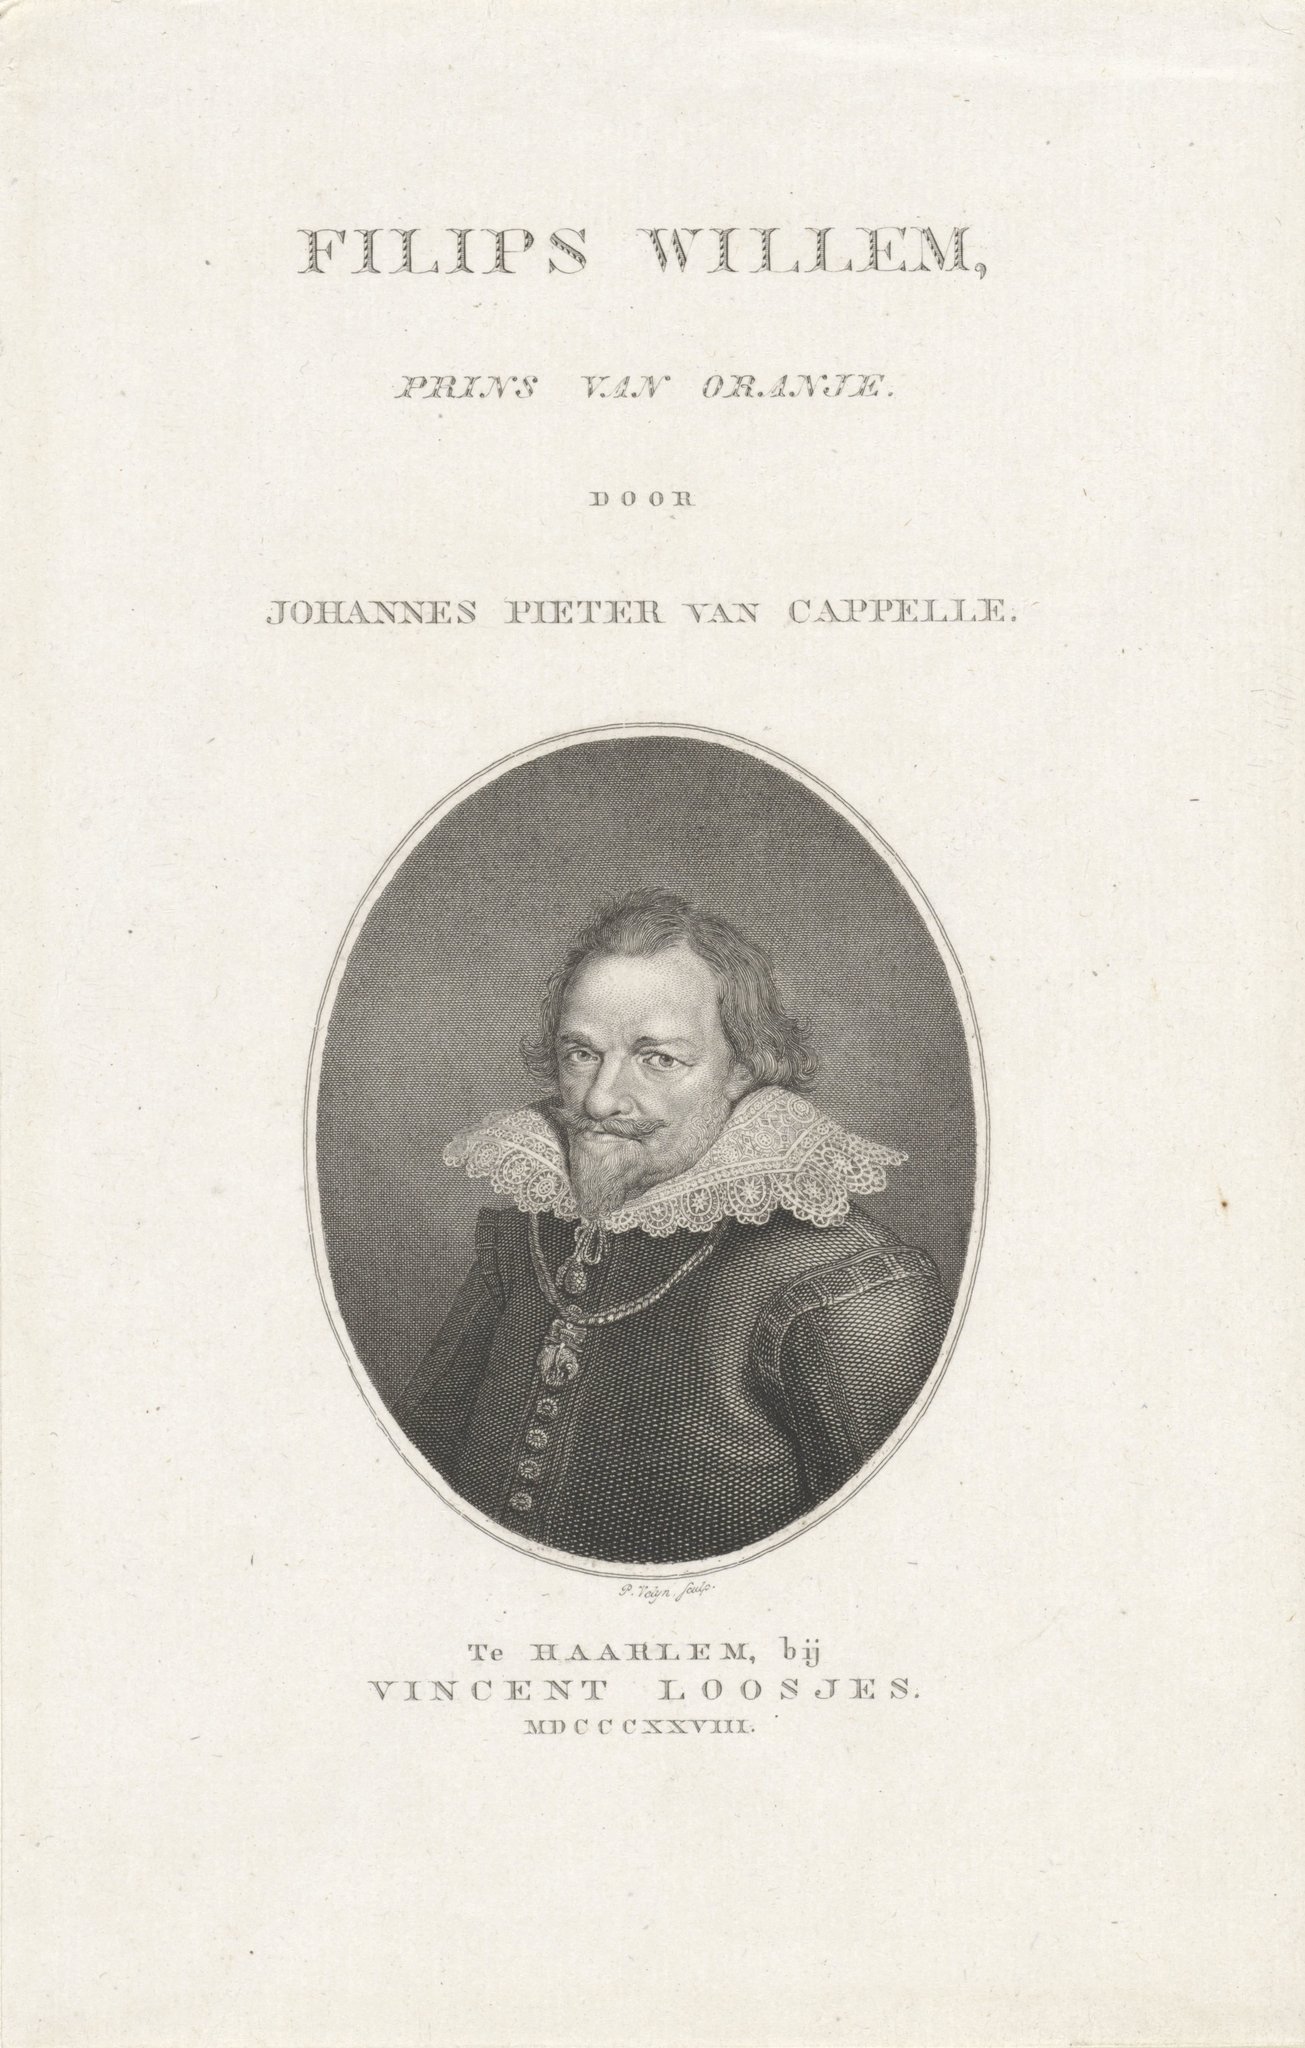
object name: print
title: Portret van Filips Willem, prins van Oranje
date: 1828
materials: paper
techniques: engraving, etching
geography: haarlem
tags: buren, filips willem (prins van oranje), knighthood order of the golden fleece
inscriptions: collector's mark: Lugt 2228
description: Portret van Filips Willem, prins van Oranje, met om zijn hals een ketting met het teken van de Orde van het Gulden Vlies.